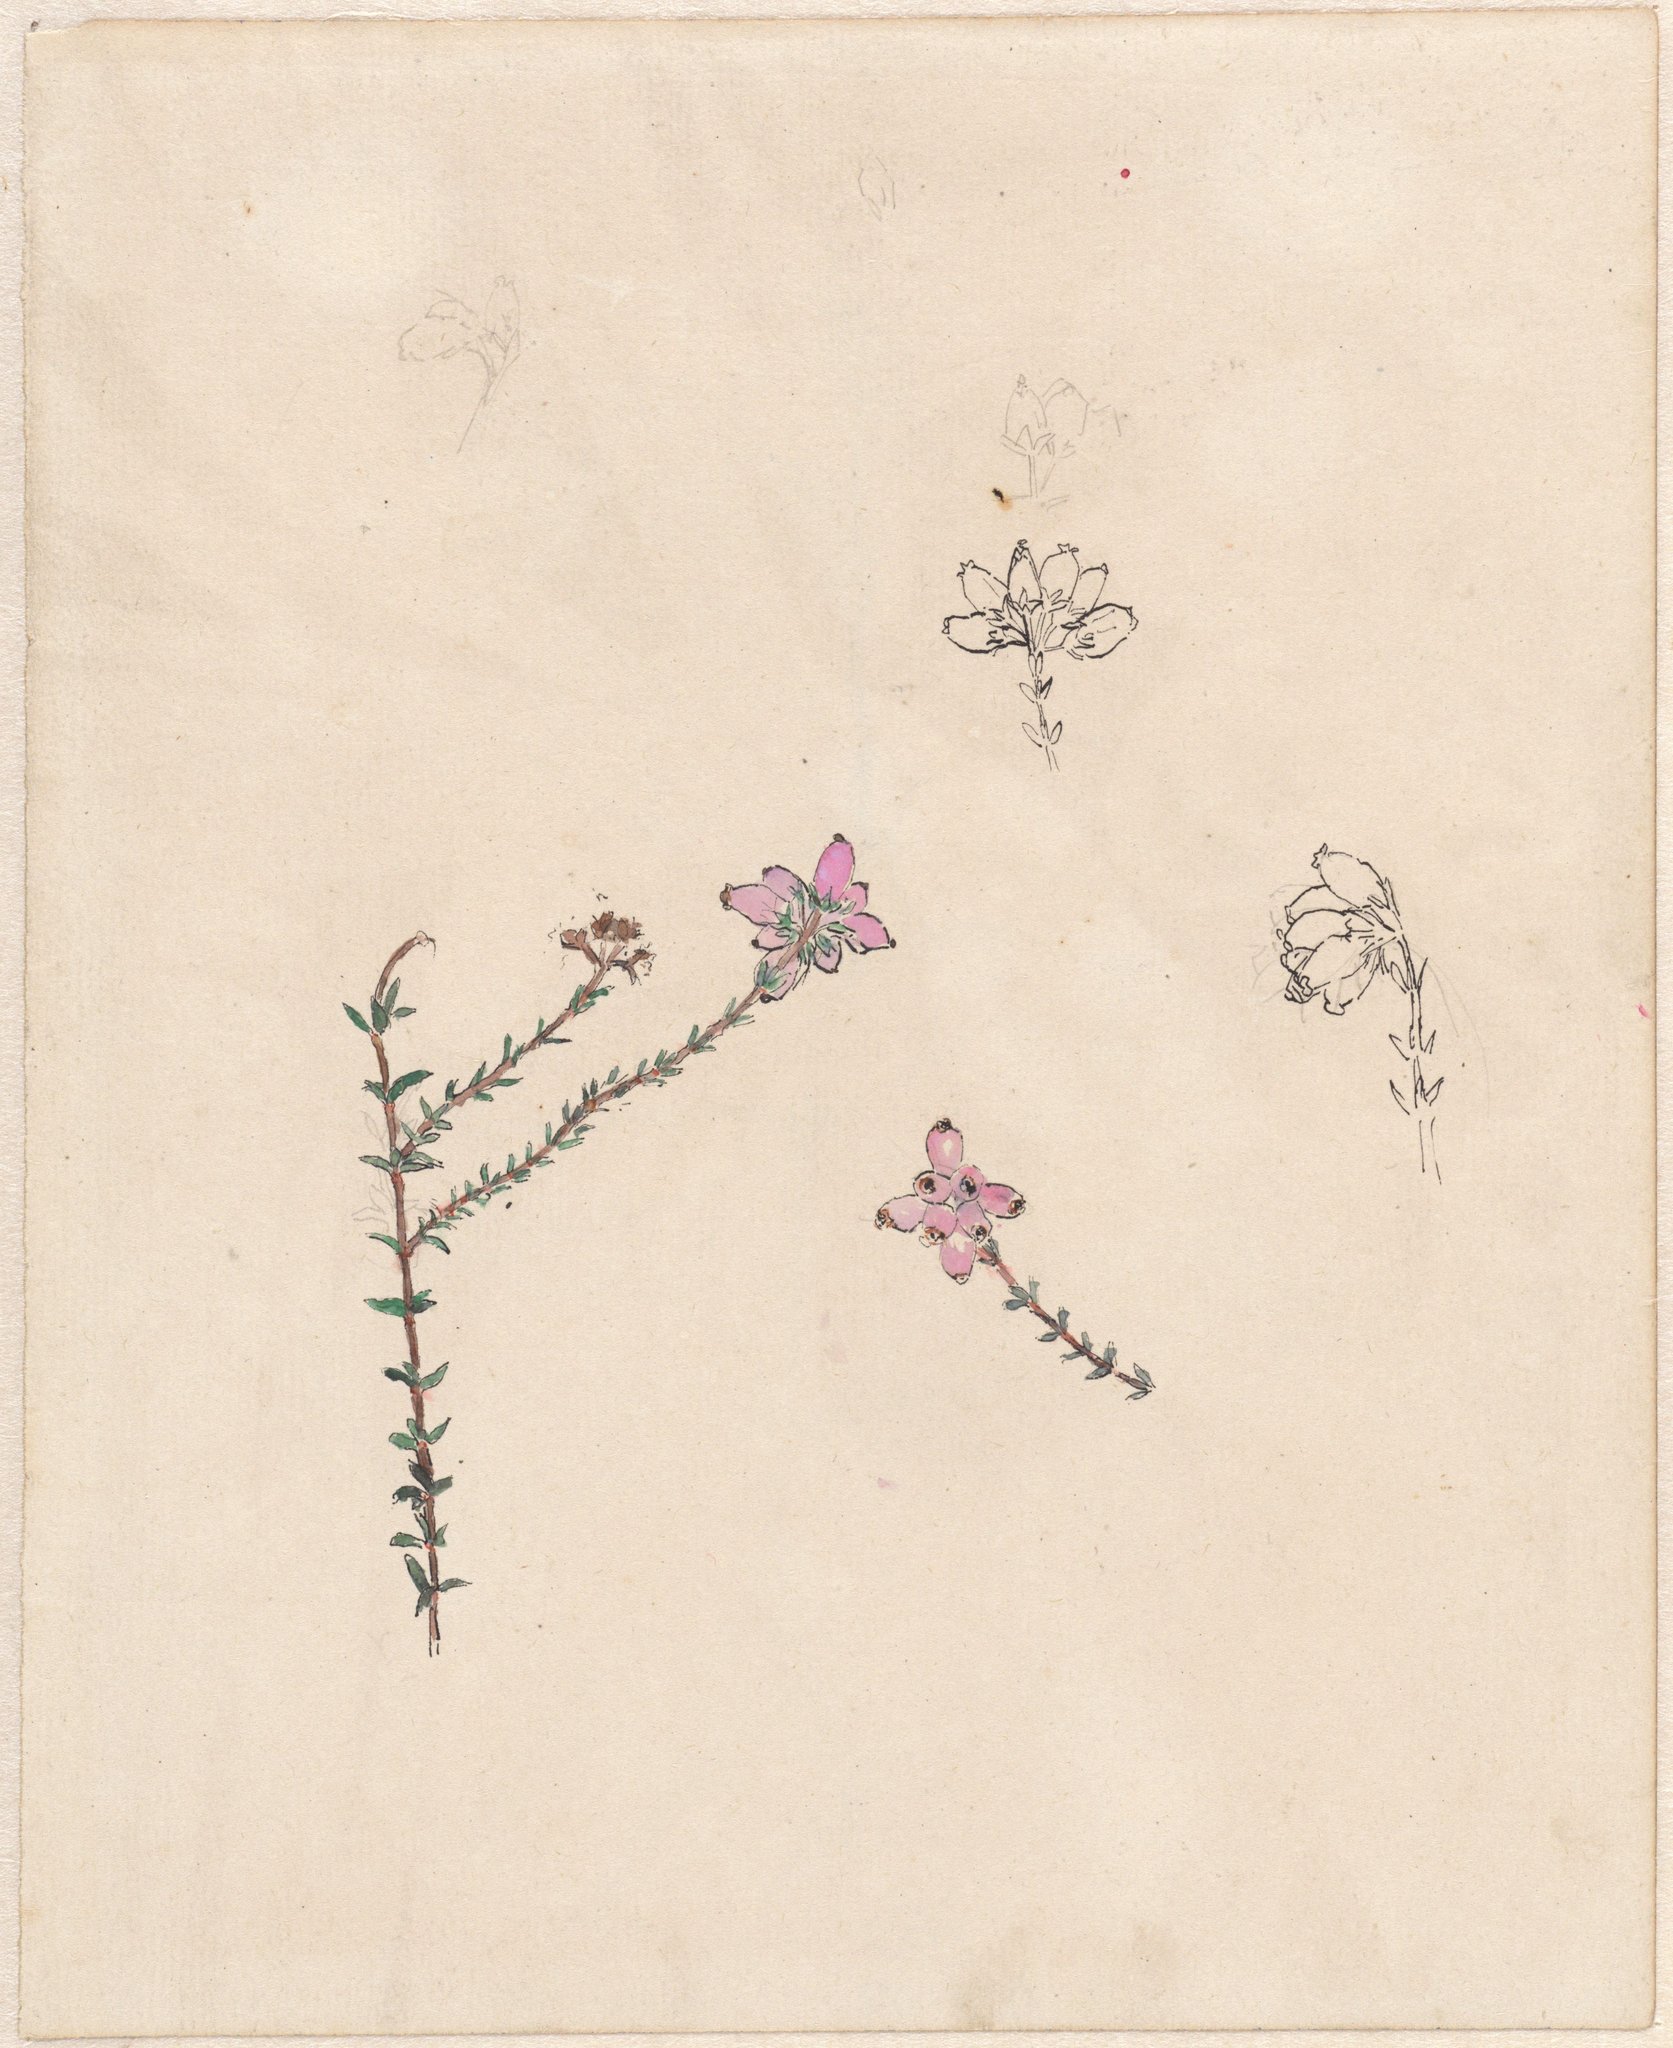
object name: drawing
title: Takje met roze knoppen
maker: theo nieuwenhuis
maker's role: designer, draughtsman, print maker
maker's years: 1866-1951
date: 1876-1951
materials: ink, paper, pencil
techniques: brush, pen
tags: flowers